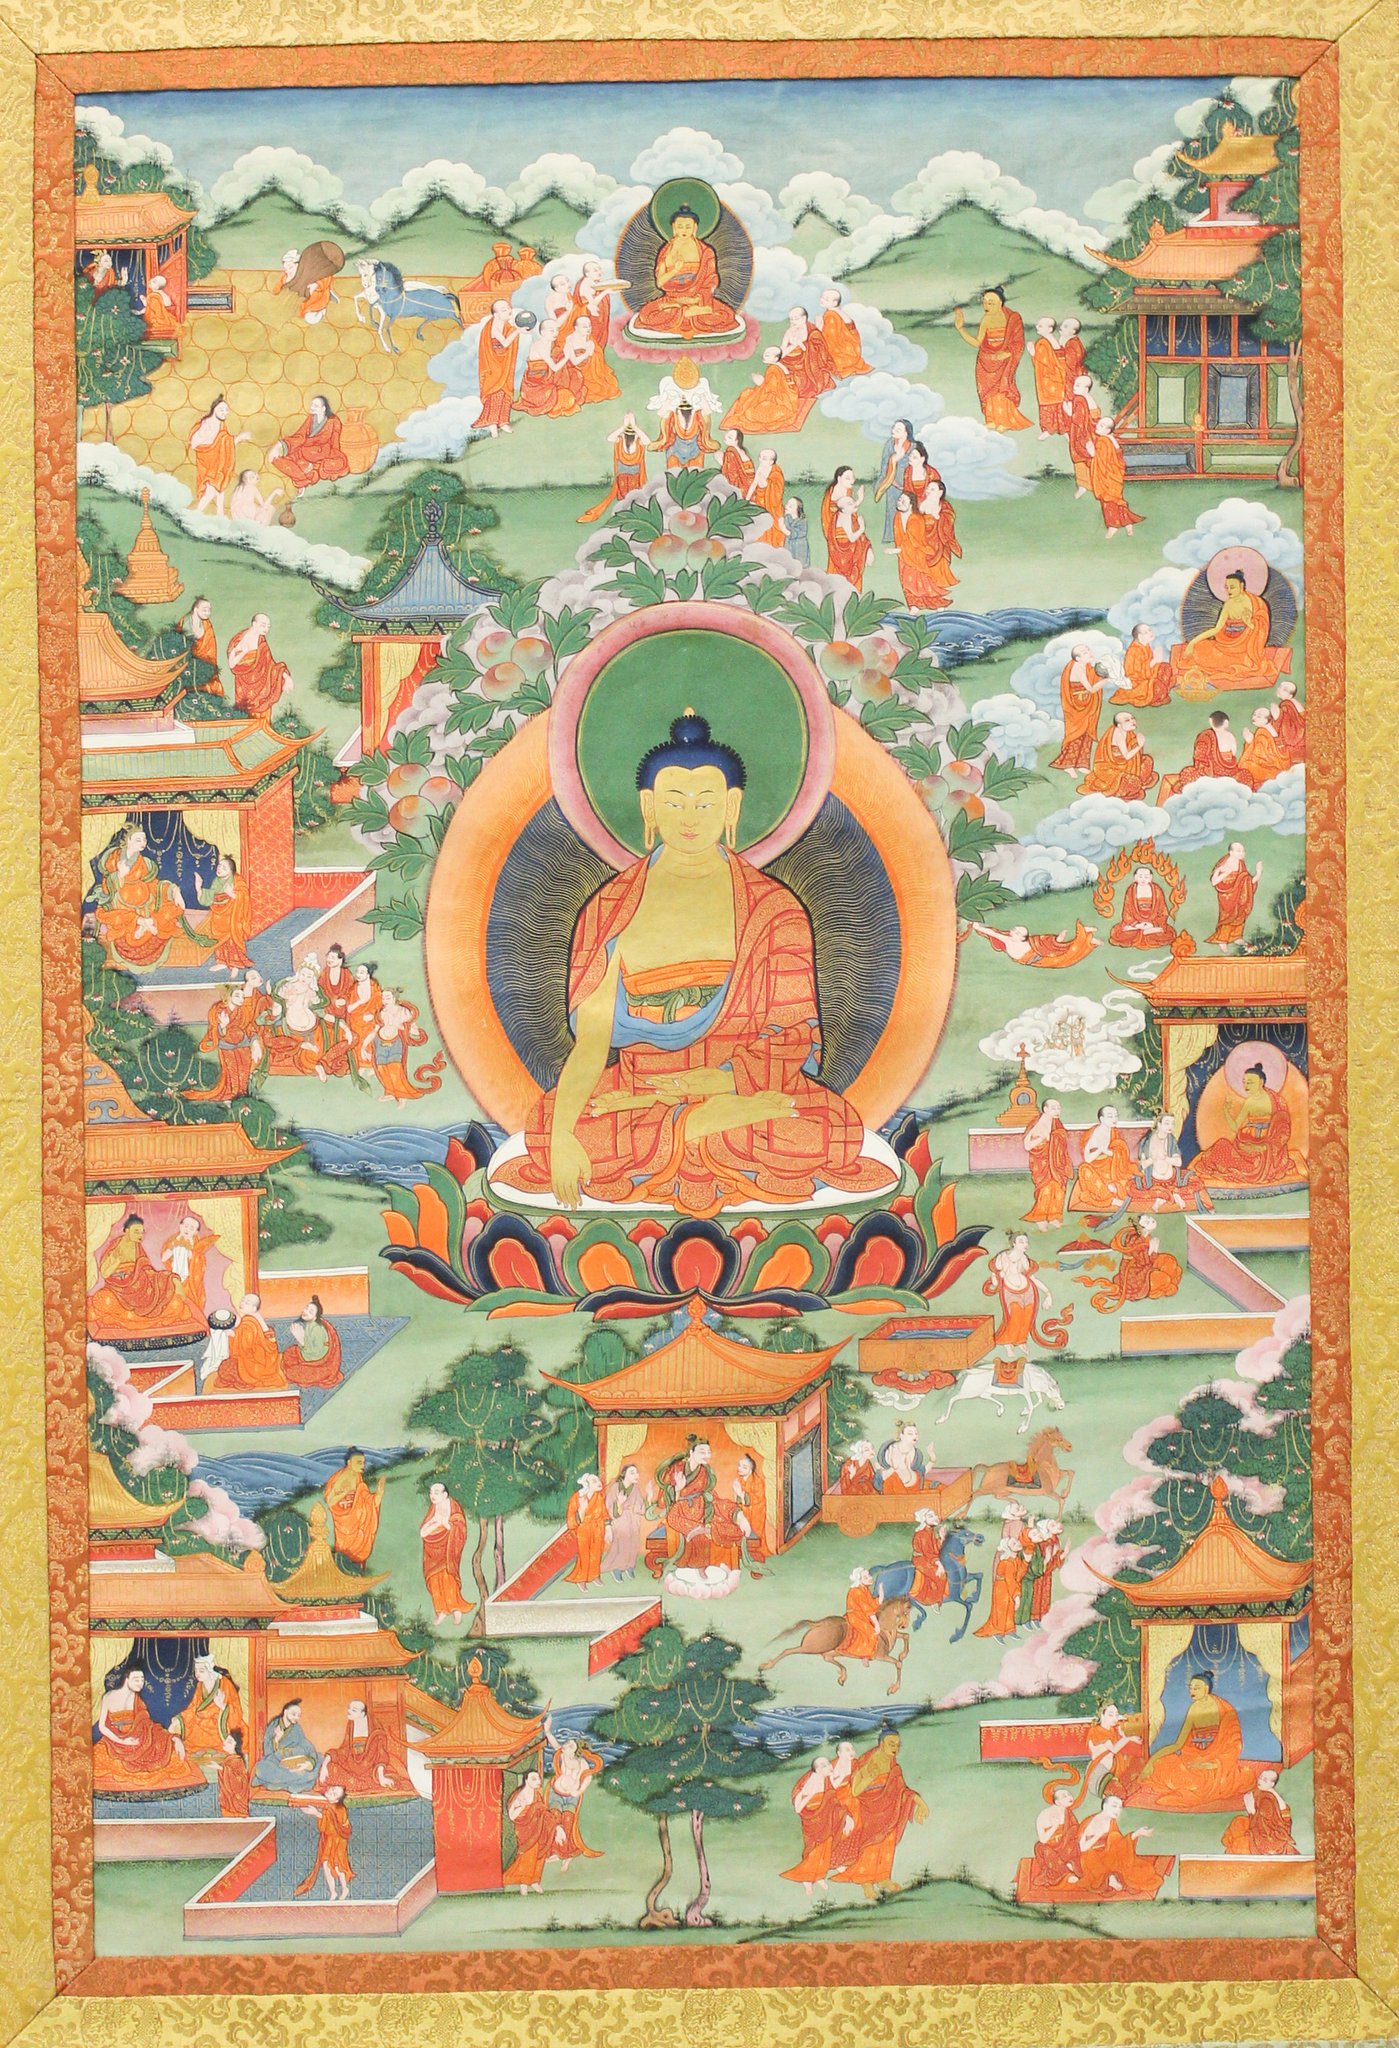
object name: thangka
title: Thangka with Buddha Seated on Lotus Pedestal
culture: tibetan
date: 1801-1900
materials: textile